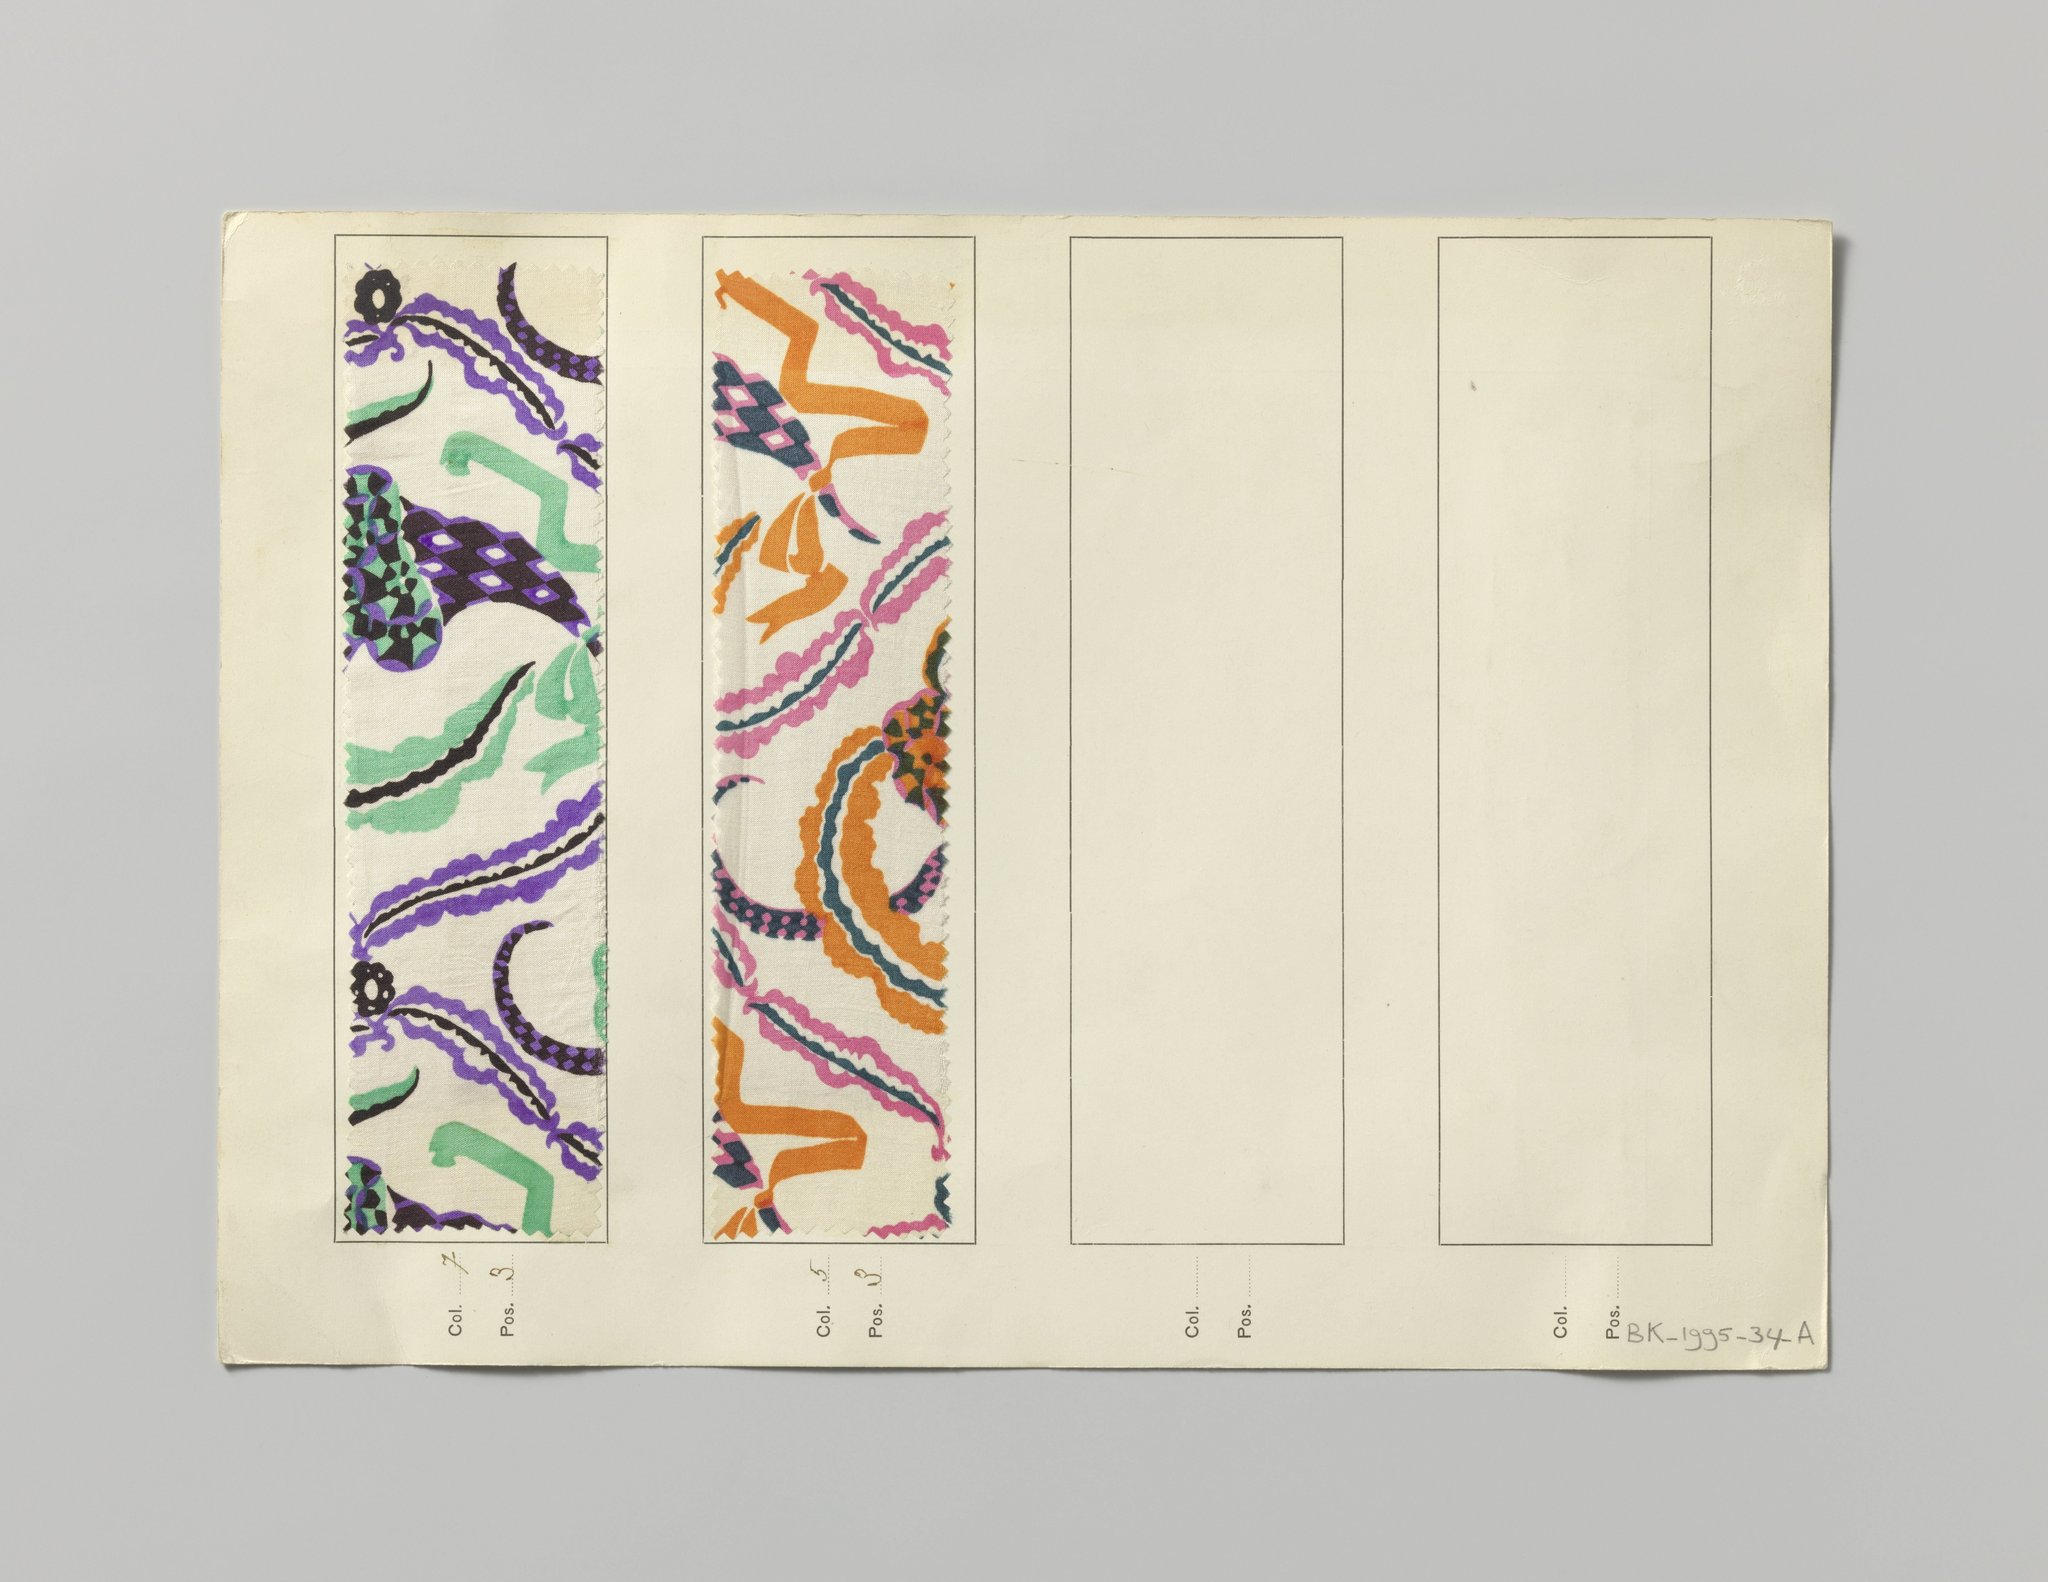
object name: sample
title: Staal met bedrukte zijde, dessin Blumenhorn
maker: dagobert peche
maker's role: designer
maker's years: 1887-1923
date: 1911-1912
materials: cardboard, silk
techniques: printing block, weave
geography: vienna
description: Staal met bedrukte zijde. Dessin Blumenhorn, WW nr. 00008. Op naturel fond bloemkorven in ruitpatroon in twee tinten bruin, blauw en zwart. De staal is gelijmd op een karton met het vignet van de Wiener Werkstätte. Aan de achterzijde twee kleurvarianten respectievelijk in paars en groen en in oranje en roze. Wenen, 1911-1912.